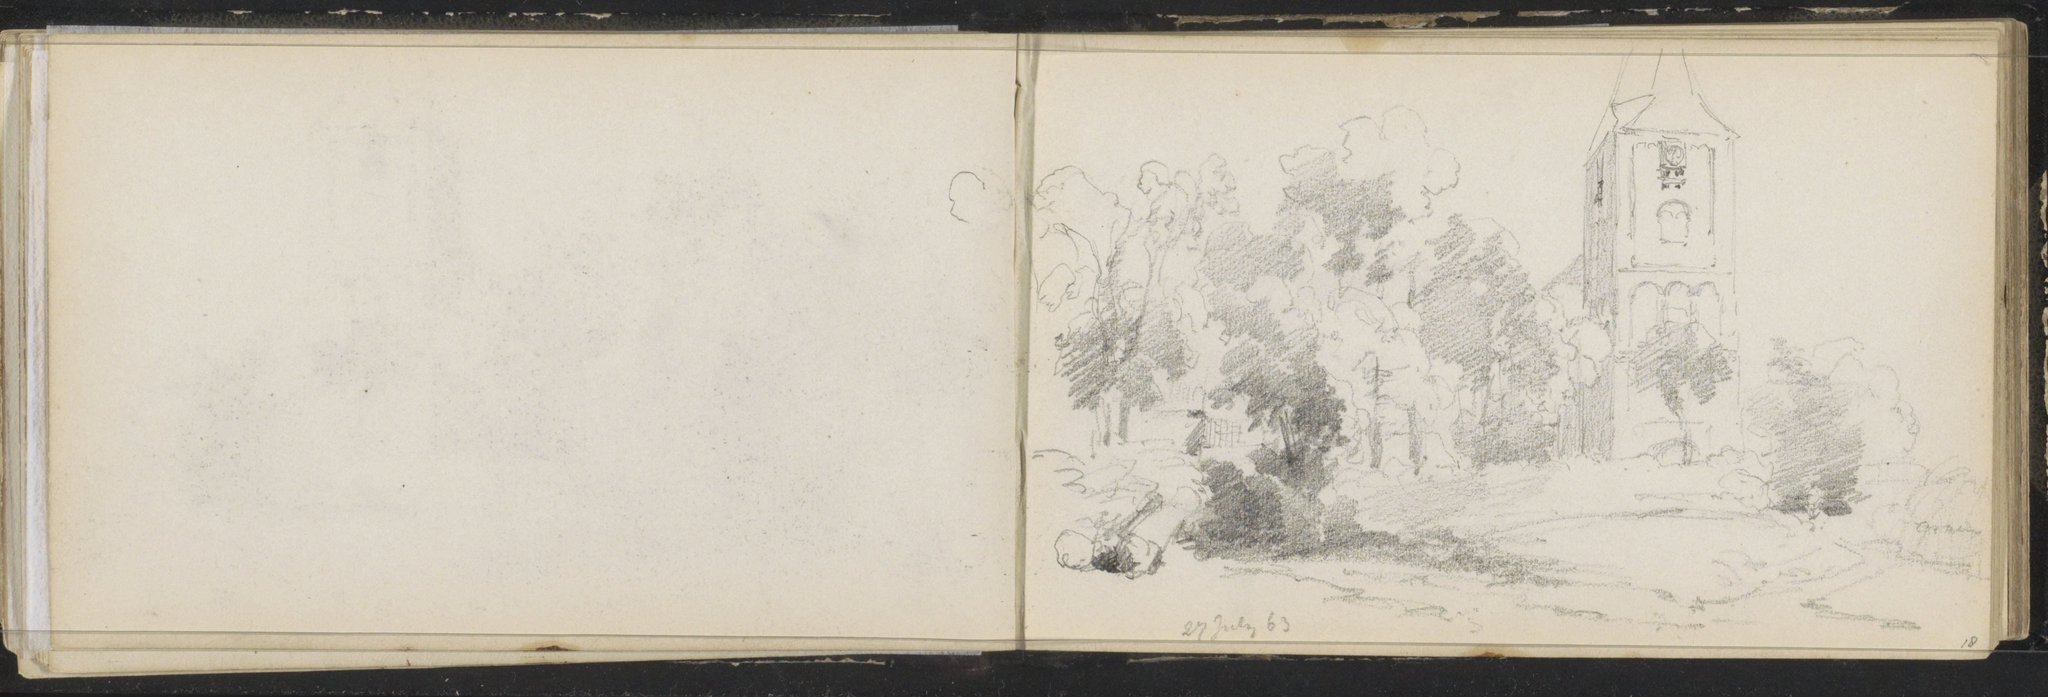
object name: sketchbook leaf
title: Gezicht op de Oude Kerk in Ermelo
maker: cornelis springer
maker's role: draughtsman, painter, print maker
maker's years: 1817-1891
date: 1863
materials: paper, pencil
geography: ermelo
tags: church (exterior)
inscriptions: date: ‘27 July 63’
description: Gezicht op de Oude Kerk in Ermelo. Blad 17 verso en blad 18 recto uit een schetsboek met 55 bladen vervaardigd op de Veluwe en in Noord-Duitsland.